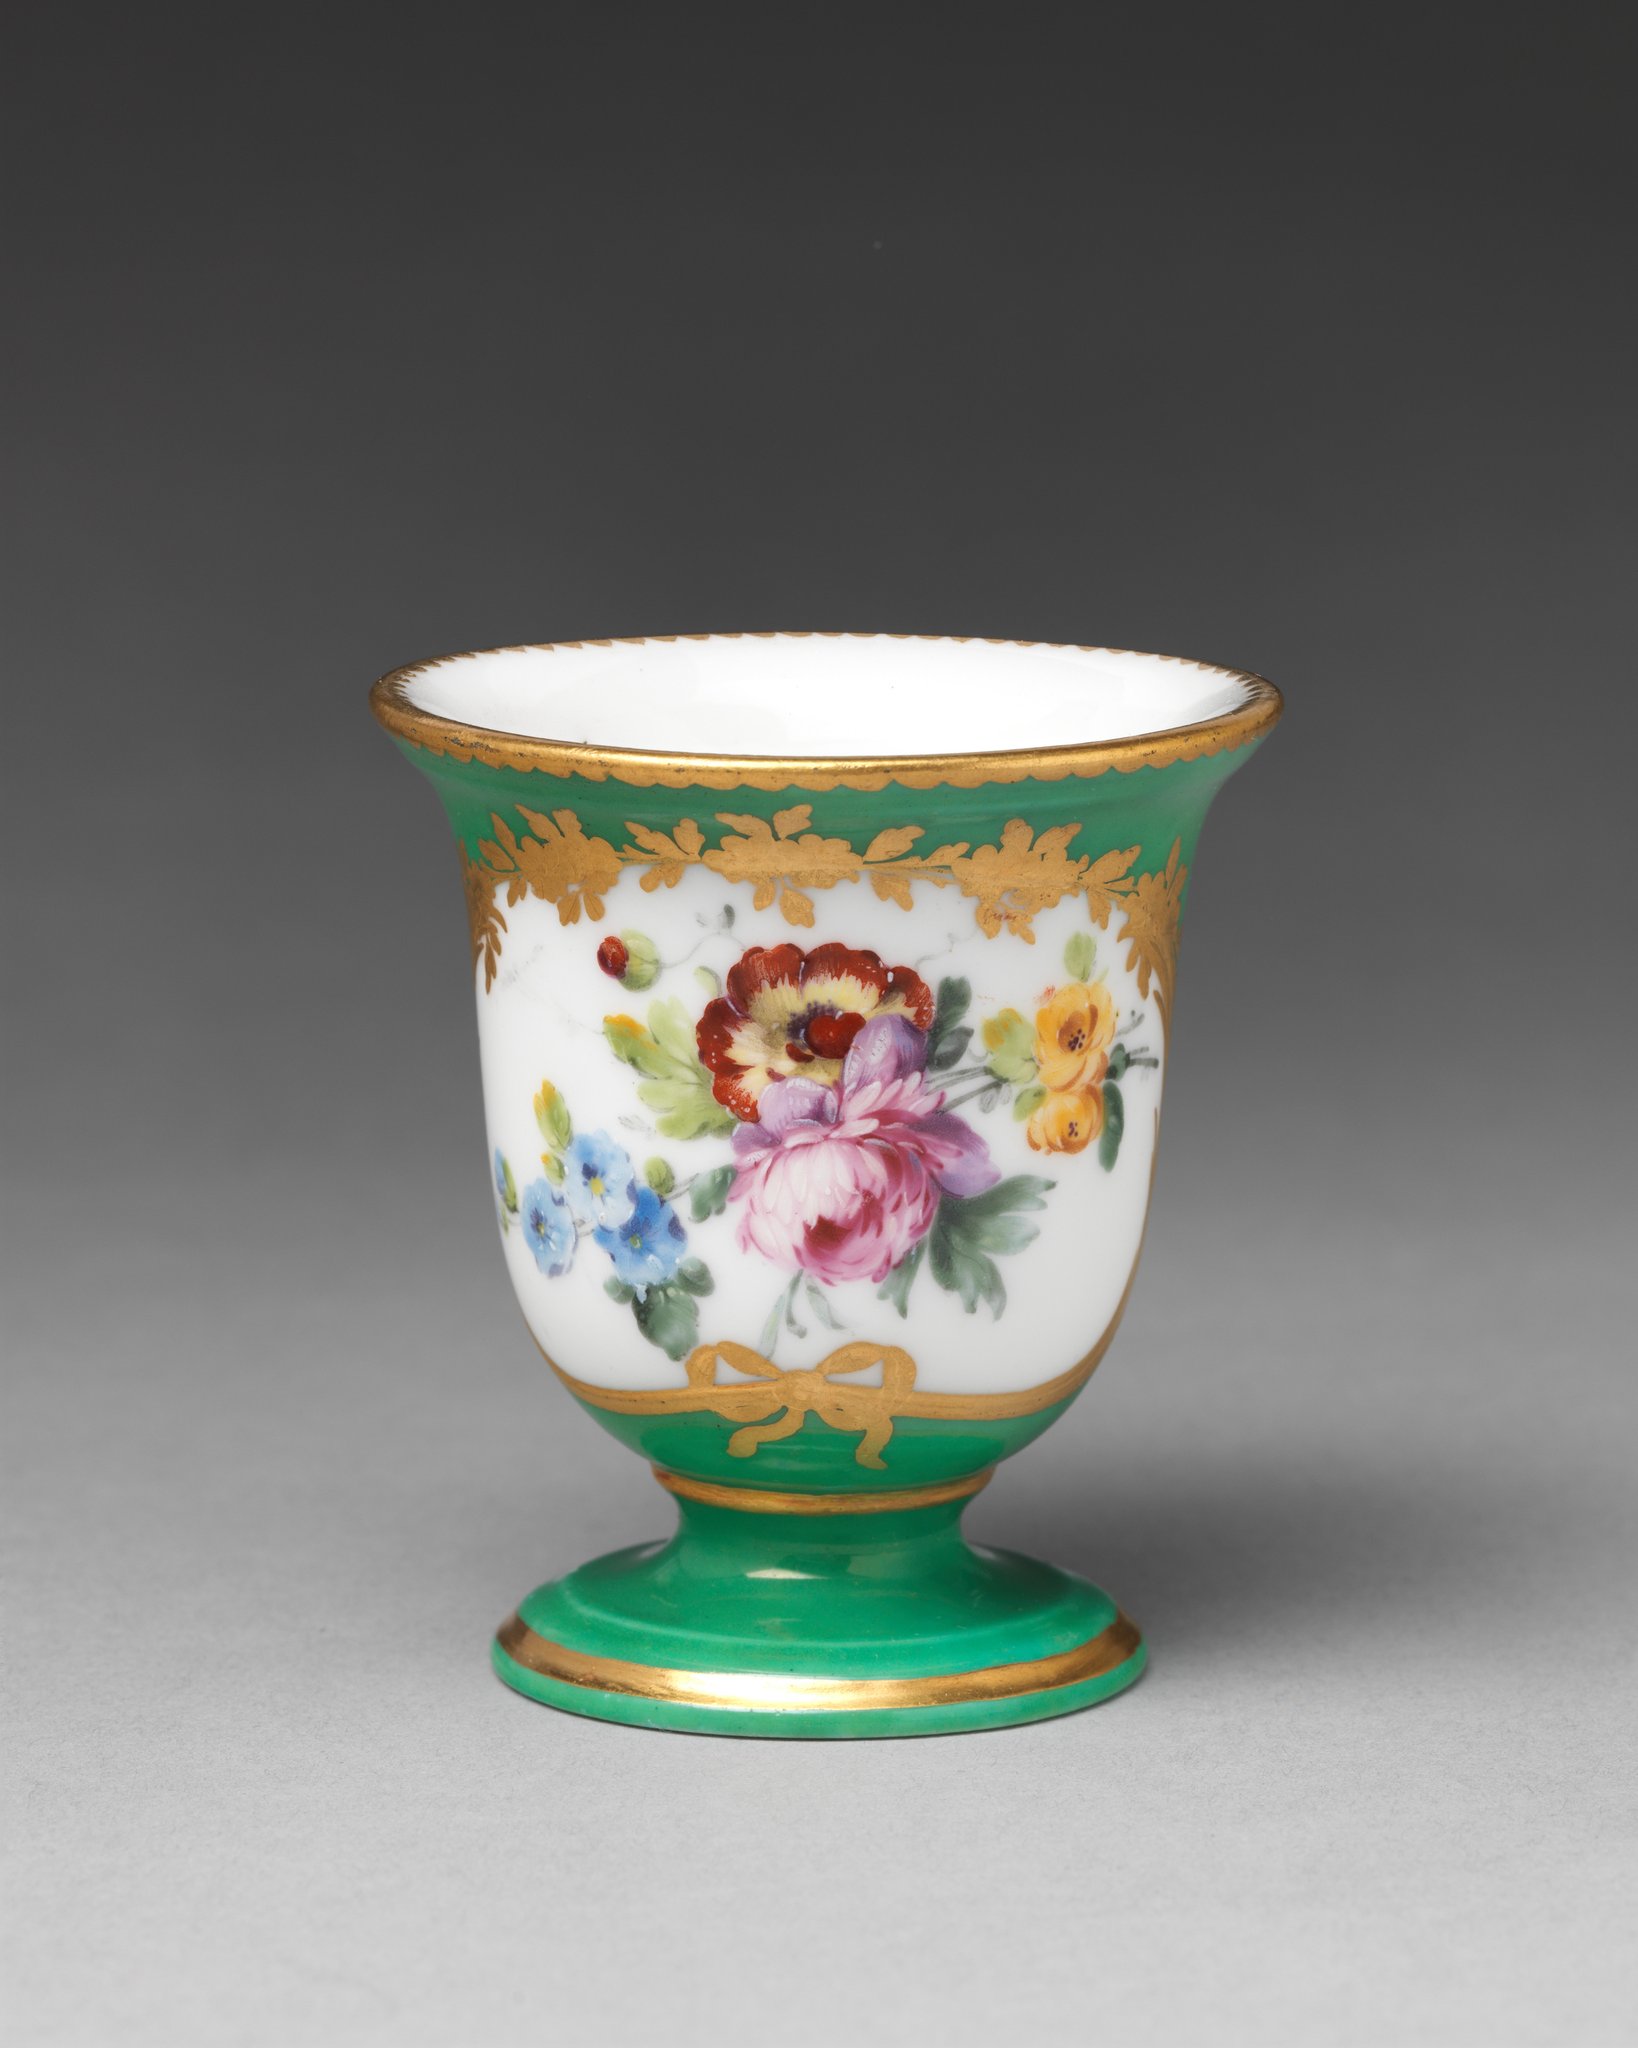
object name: ice cream cup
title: Ice cream cup (Tasse à glace) (part of a service)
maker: sèvres manufactory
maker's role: manufactory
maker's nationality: french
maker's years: 1740-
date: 1771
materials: soft paste porcelain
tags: flowers